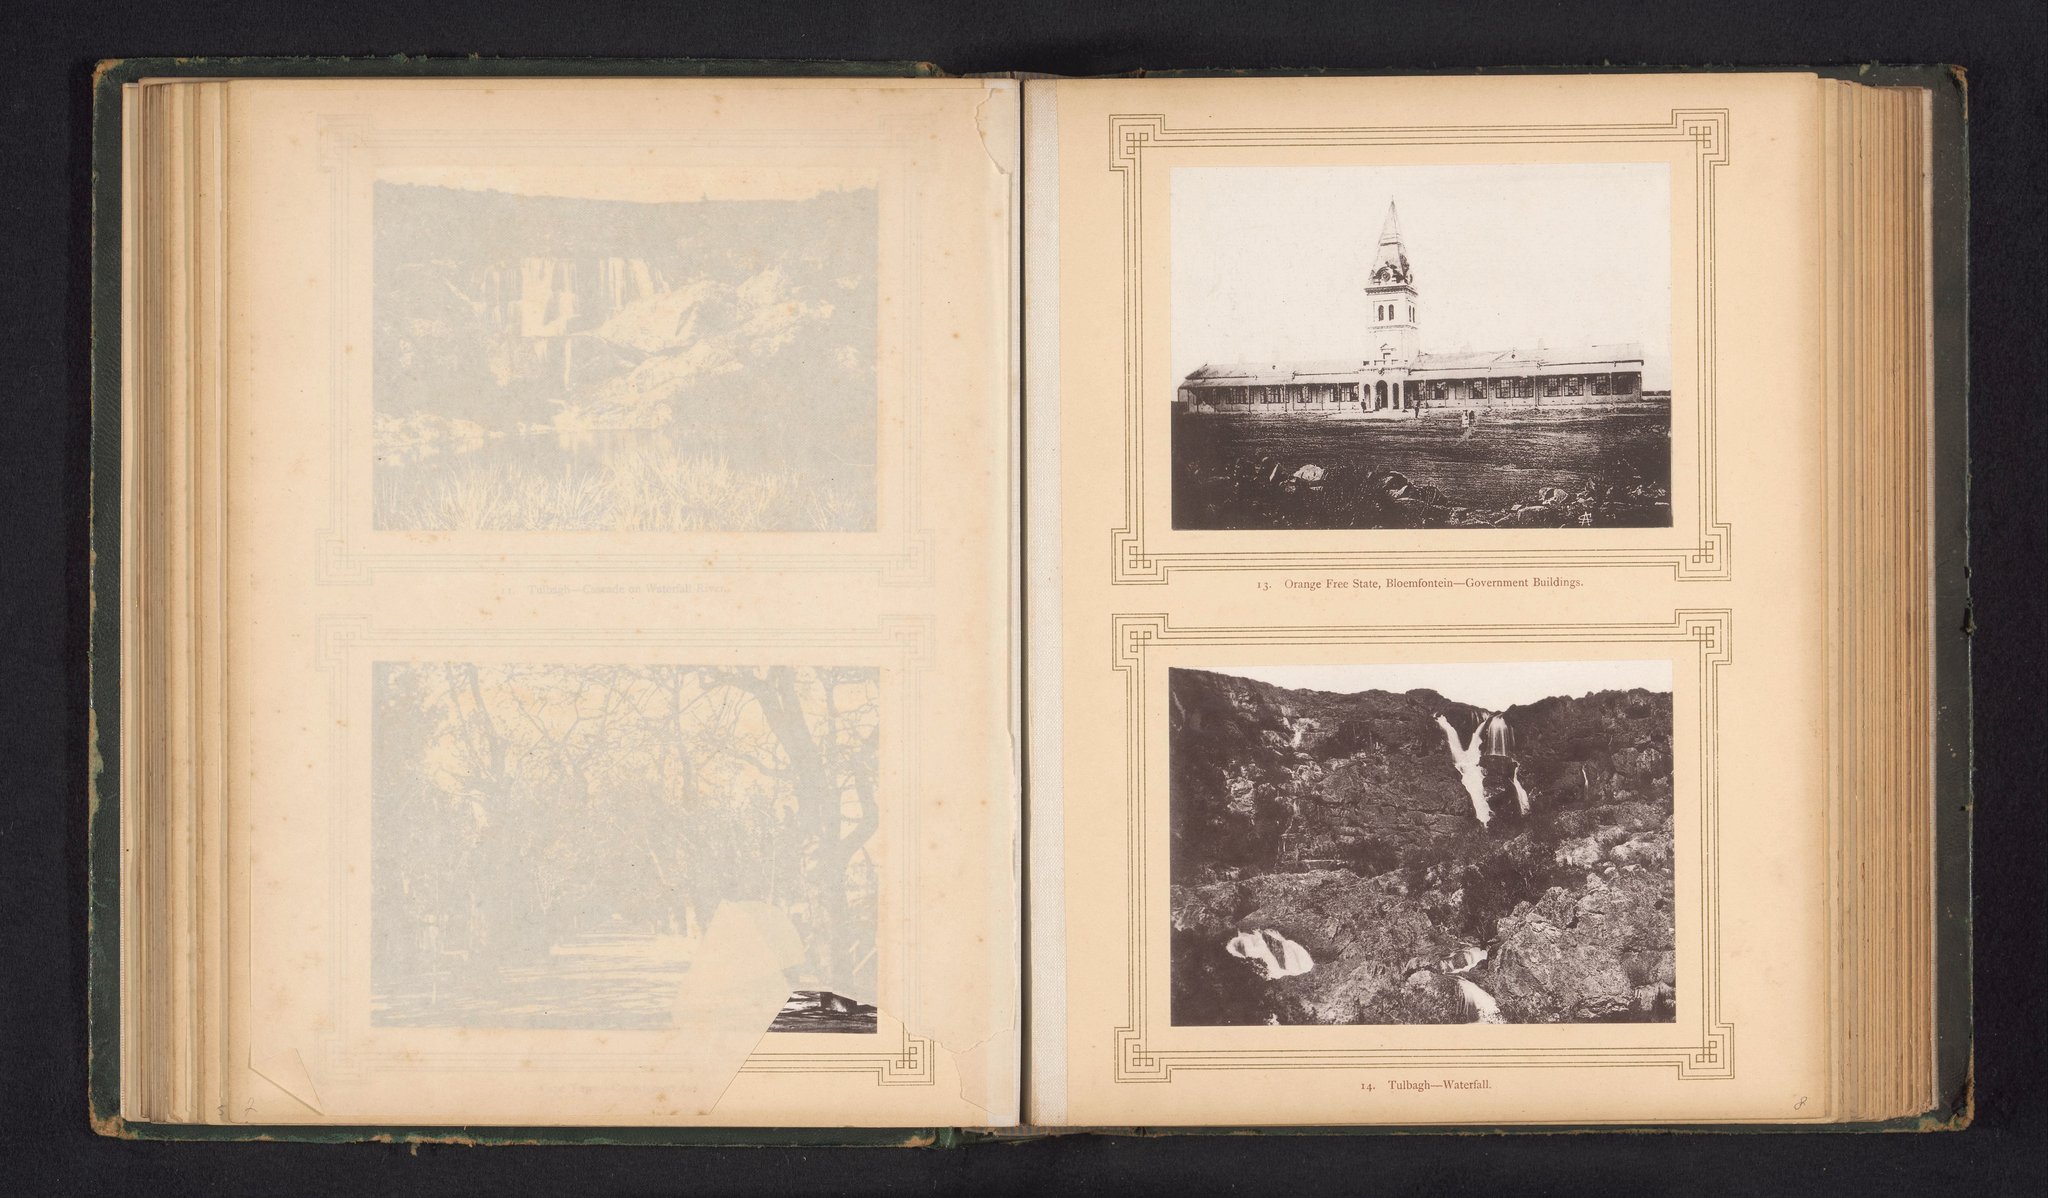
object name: page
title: Orange Free State, Bloemfontein-Government buildings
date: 1870-1880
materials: paper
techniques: photograph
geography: south africa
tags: government services, public services, waterfall, façade (of house or building)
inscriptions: inscription: ‘SA’, number: ‘13. 14.’